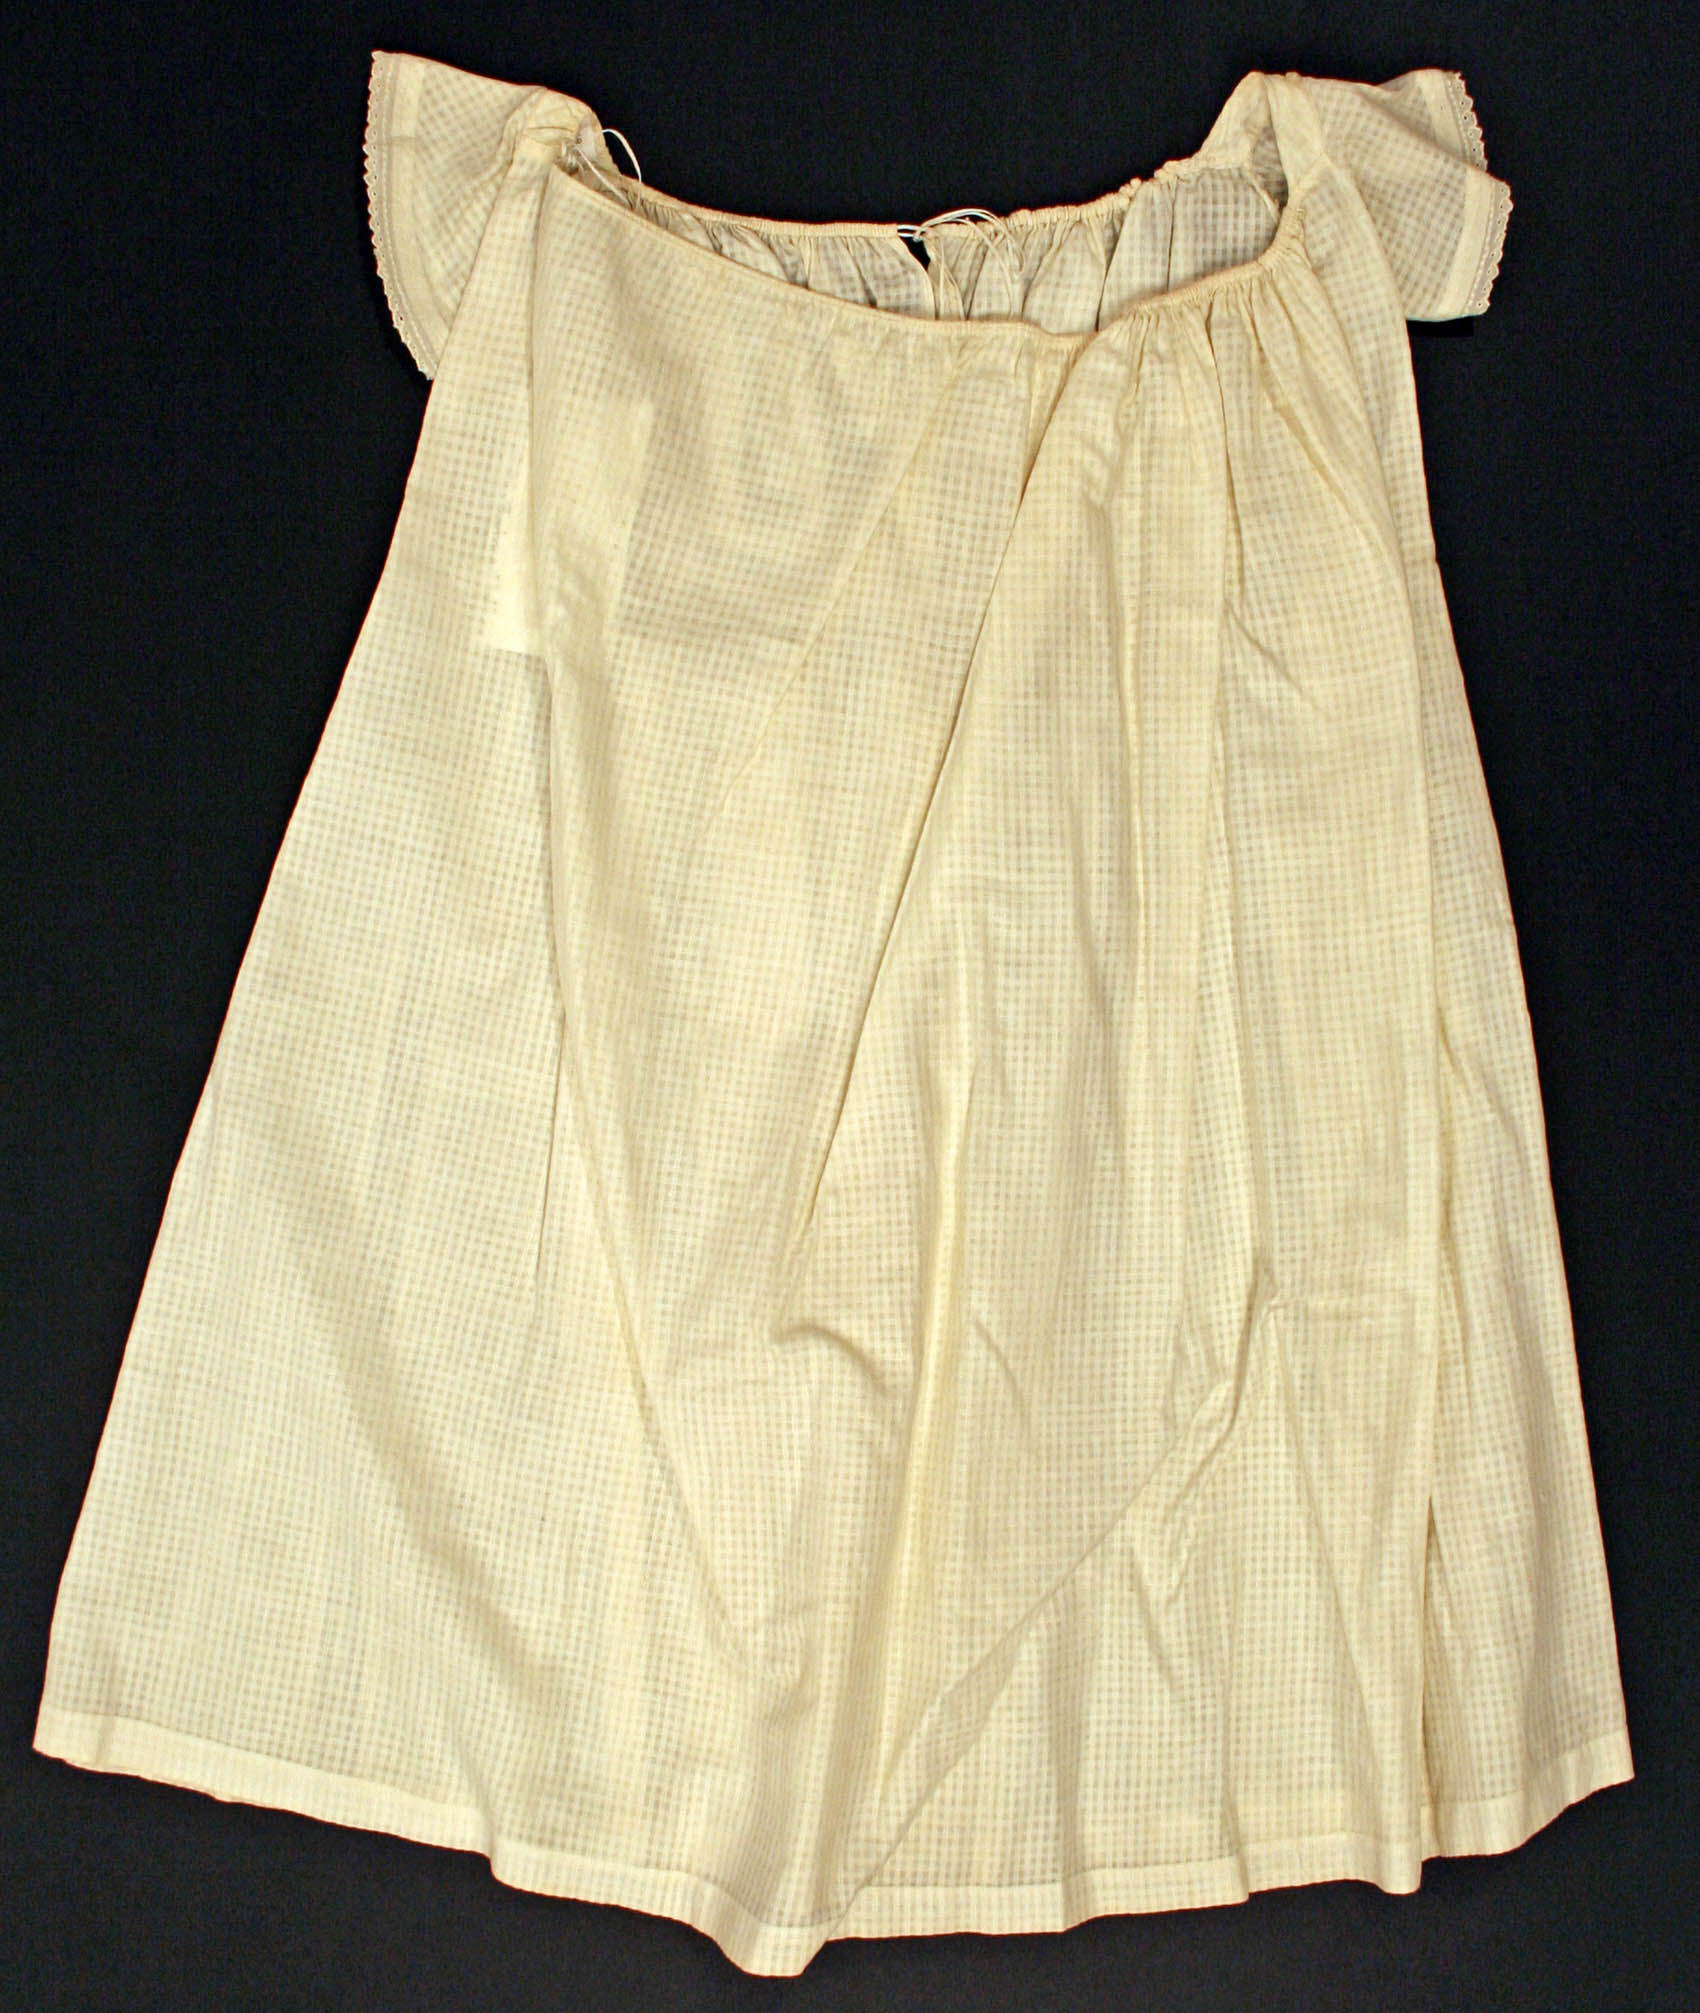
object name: dress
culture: american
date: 1860-1869